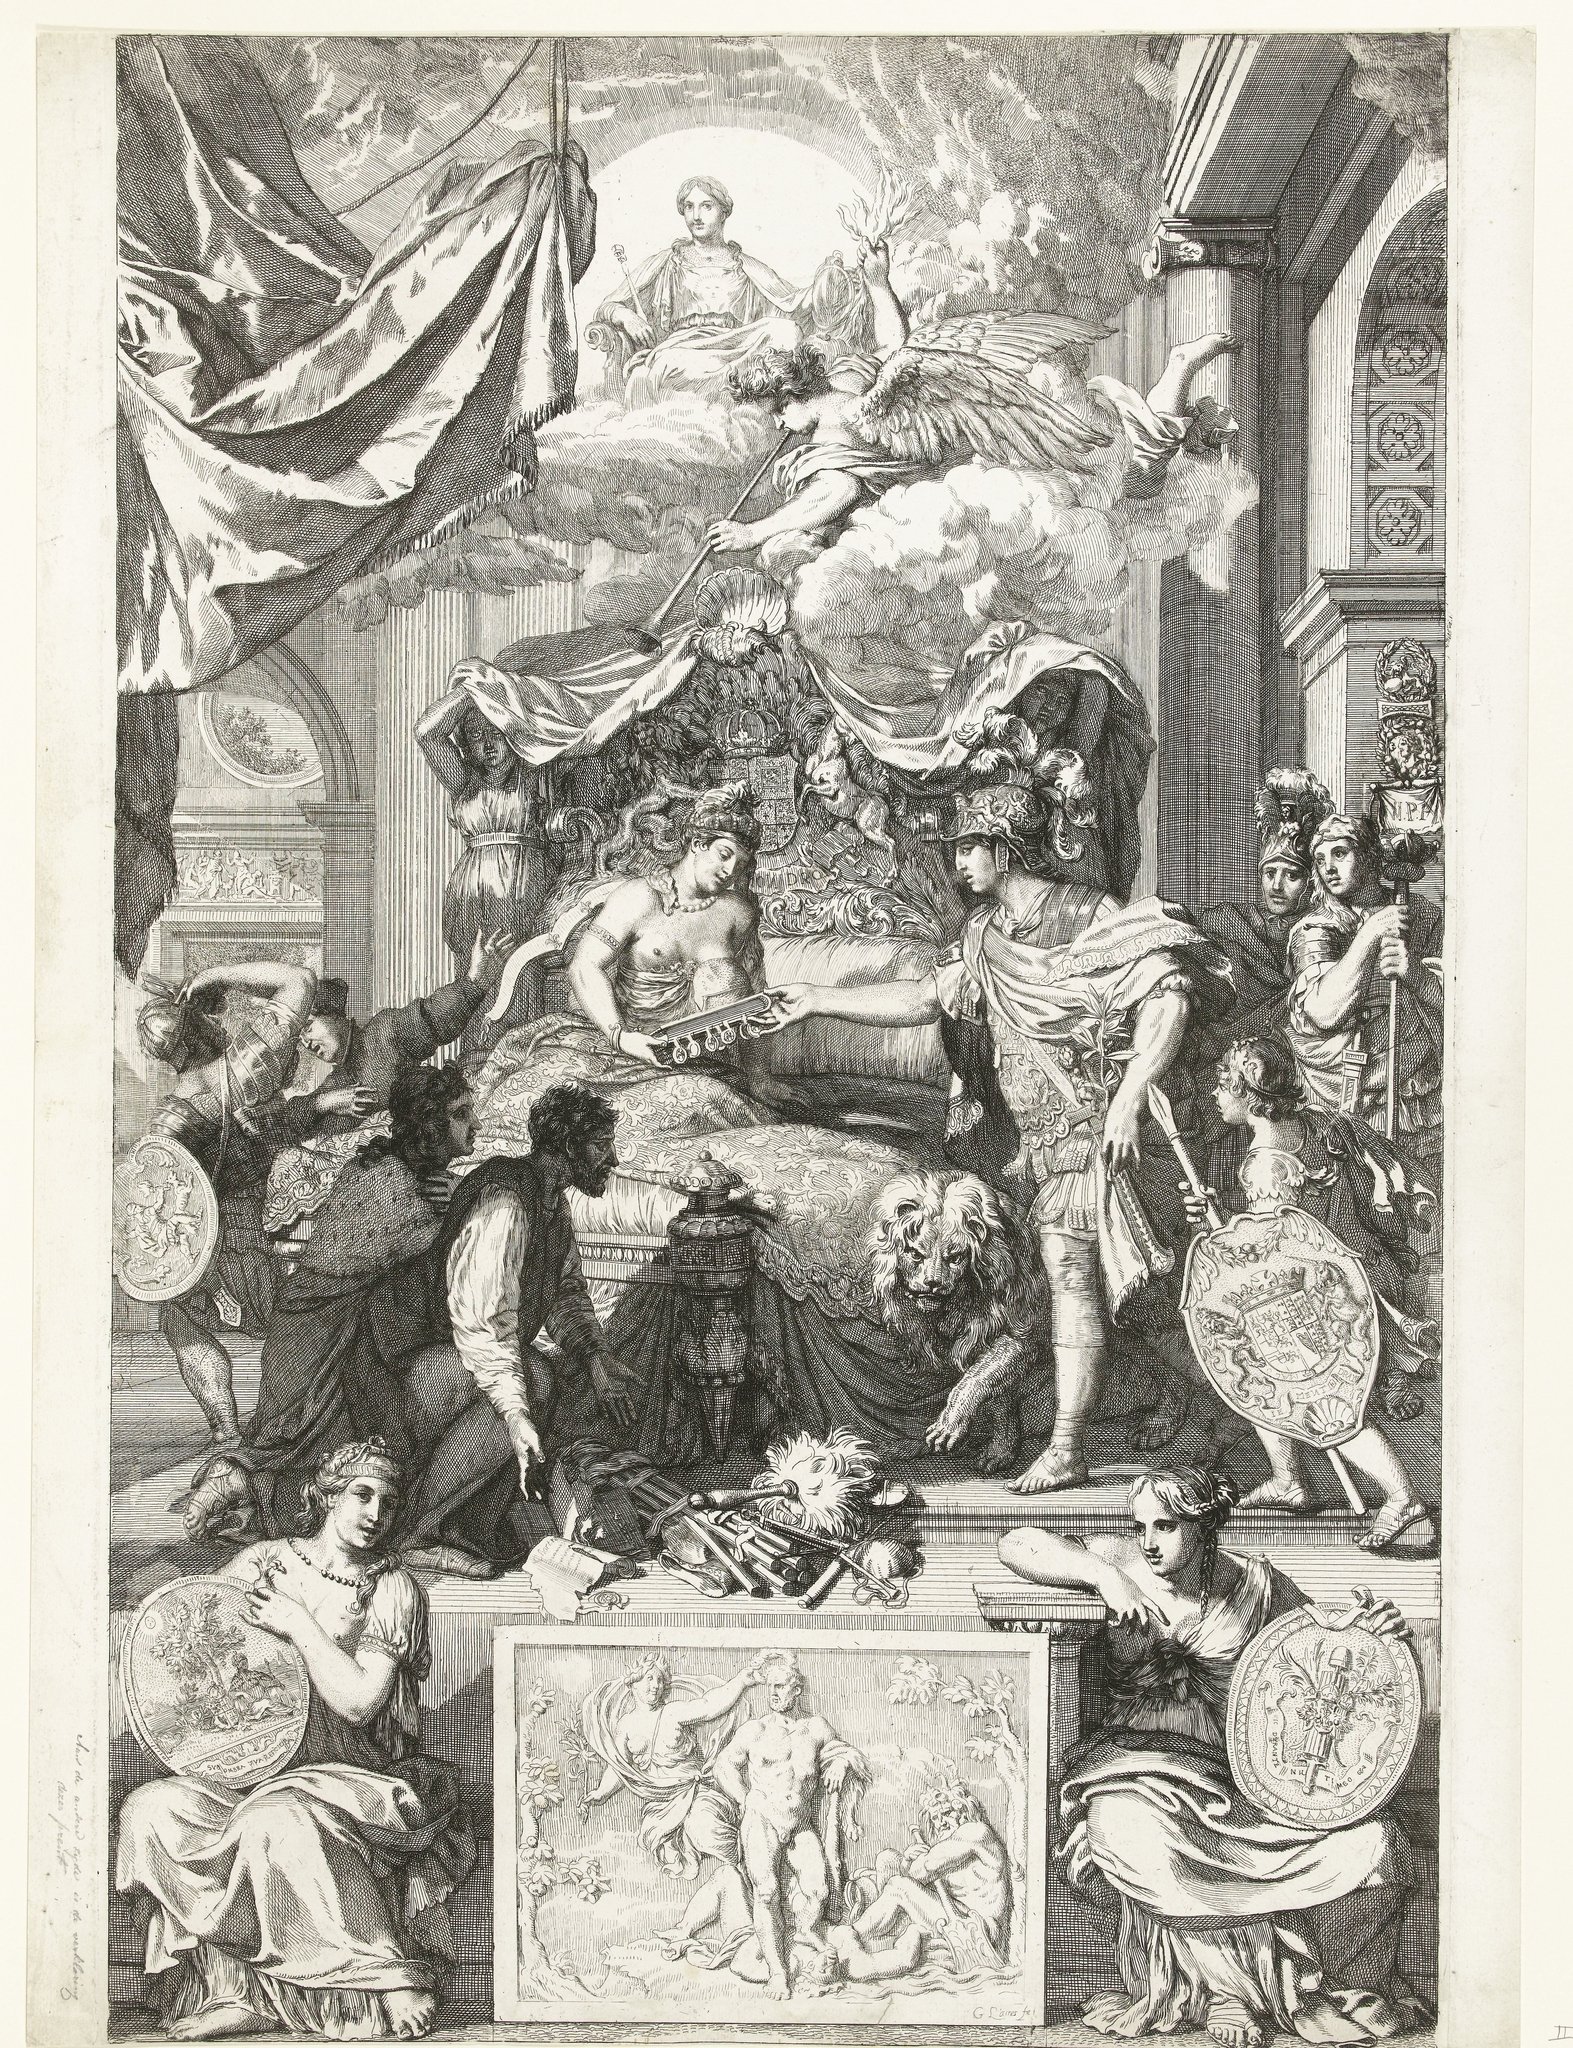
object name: propagandaprent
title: Allegorie op het herstel van de ware godsdienst in Engeland met de komst van de prins van Oranje, 1688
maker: gerard de lairesse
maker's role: draughtsman, painter, print maker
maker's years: 1641-1711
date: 1688-1689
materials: paper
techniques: etching, letterpress printing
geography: northern netherlands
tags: william iii (prince of orange and king of england, scotland, and ireland), personifications of countries, nations, states, districts, etc., truth; 'verità' (ripa), england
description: Allegorie op het herstel van de ware godsdienst in Engeland met de komst van de prins van Oranje, 1688. Allegorie waarin een romeinse veldheer, Willem III, vergezeld van de Hollandse Leeuw een verzegelde bijbel overhandigt aan de Engelse Maagd, door haar heer verlaten liggend in bed. Aan het voeteneind knielen de Engelse lord en burger. In de lucht de engel van de wraak Gods met bliksemschichten en bazuin en de tronende Waarheid. Op de voorgrond twee vrouwenfiguren zittend aan weerszijden van een fries met een voorstelling van Hercules gekroond. Op de achterzijde van het blad is een gedrukte verklaring geplakt. Bij de prent behoort een tekstblad.